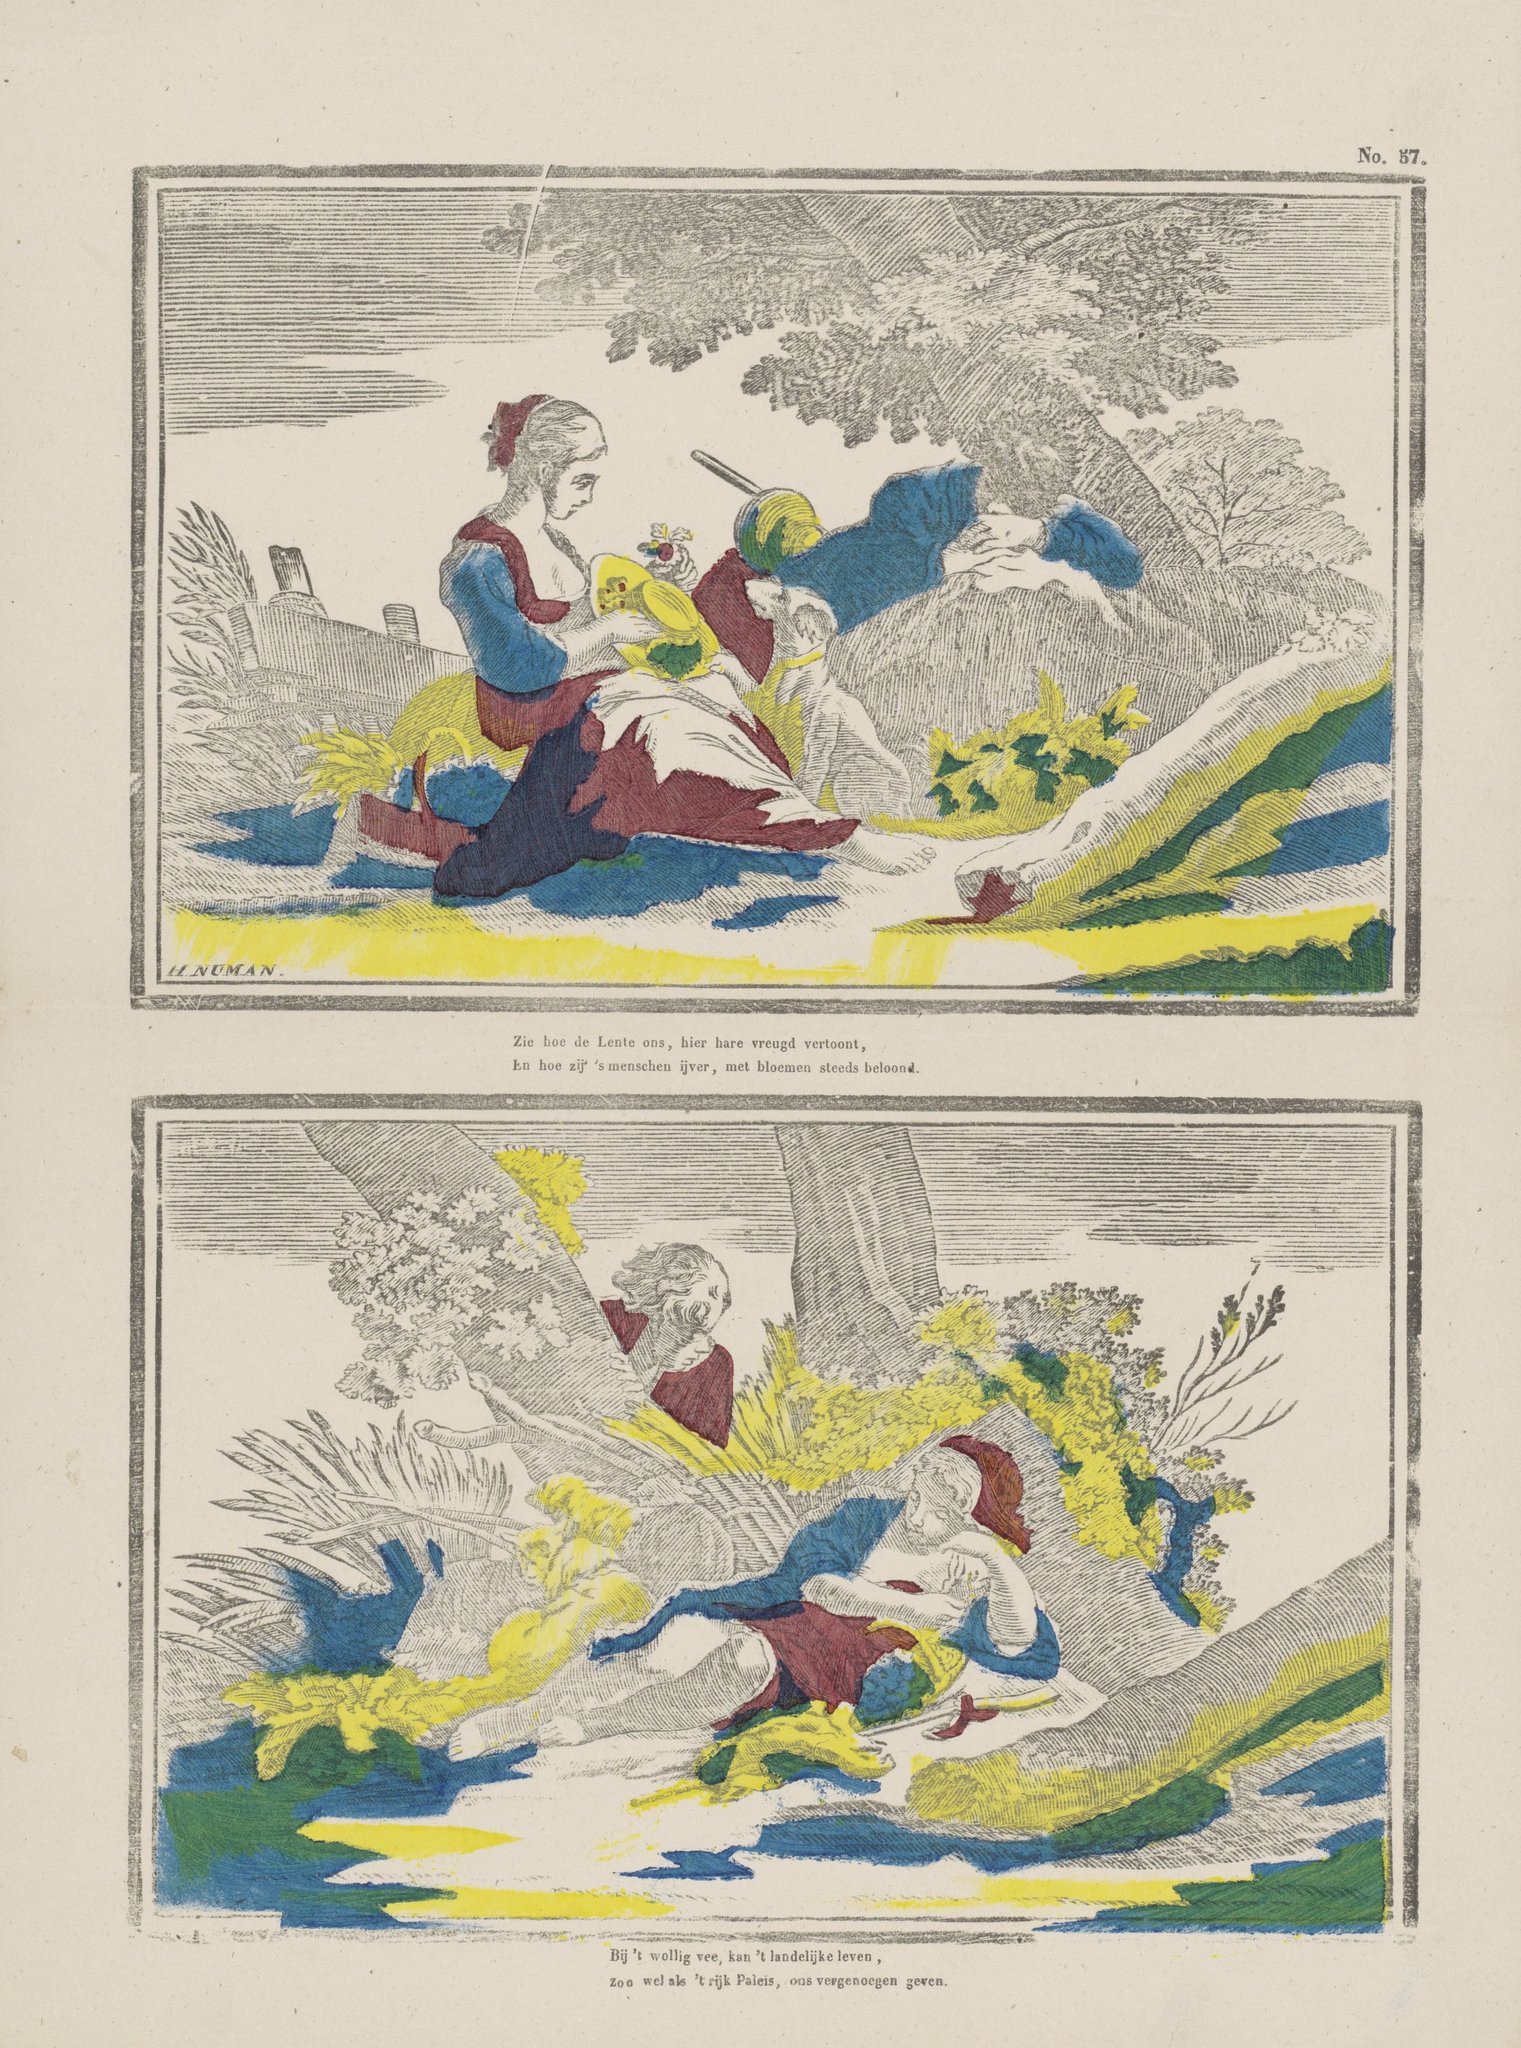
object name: print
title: Landelijke taferelen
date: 1848-1881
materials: paper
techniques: colour, letterpress printing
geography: den bosch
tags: resting - bb - out of doors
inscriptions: collector's mark: Lugt 2760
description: Blad met 2 voorstellingen van mensen die liggen te rusten in de natuur. Onder elke afbeelding een tweeregelig vers. Genummerd rechtsboven: No. 57.